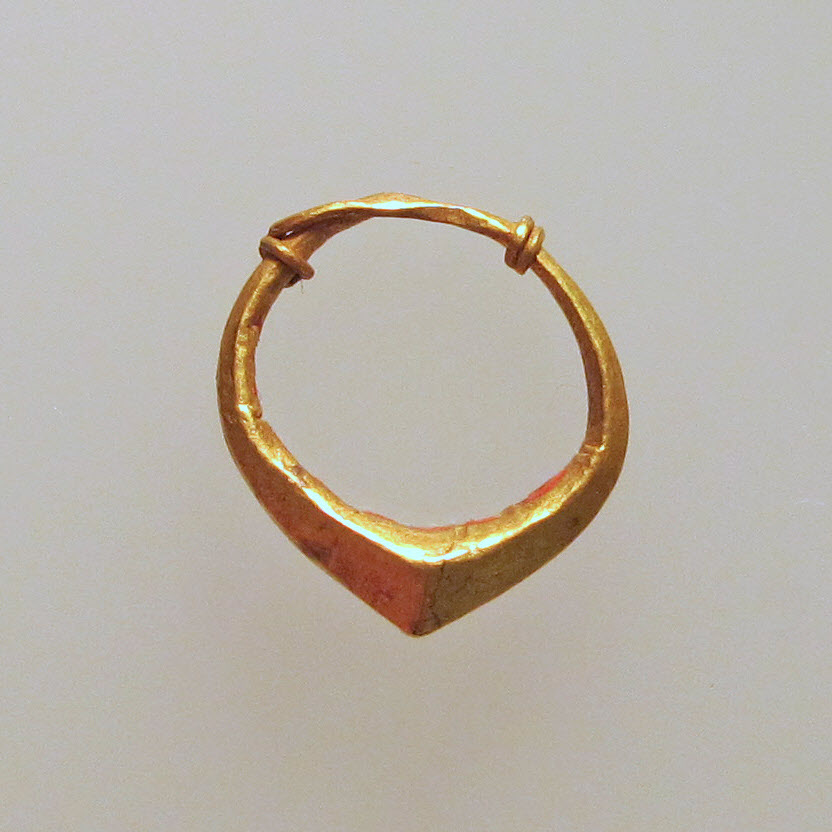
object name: earring of simple form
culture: cypriot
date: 3900 BCE-100 CE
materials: gold